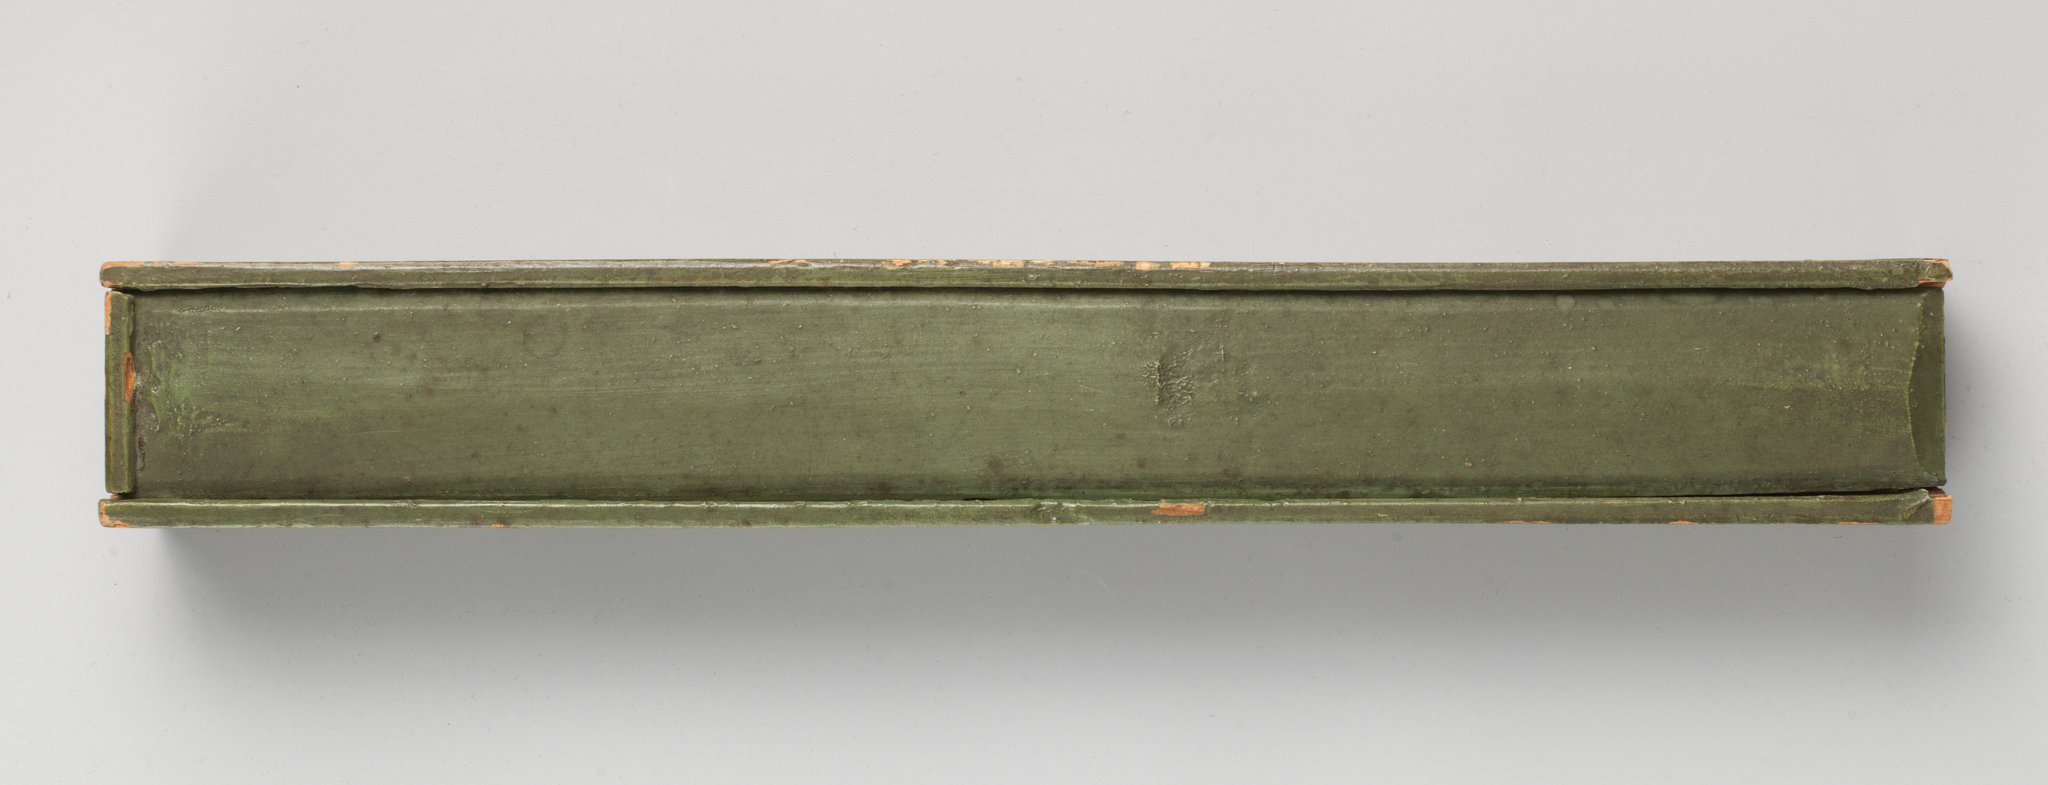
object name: fan box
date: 1801-1900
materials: wood